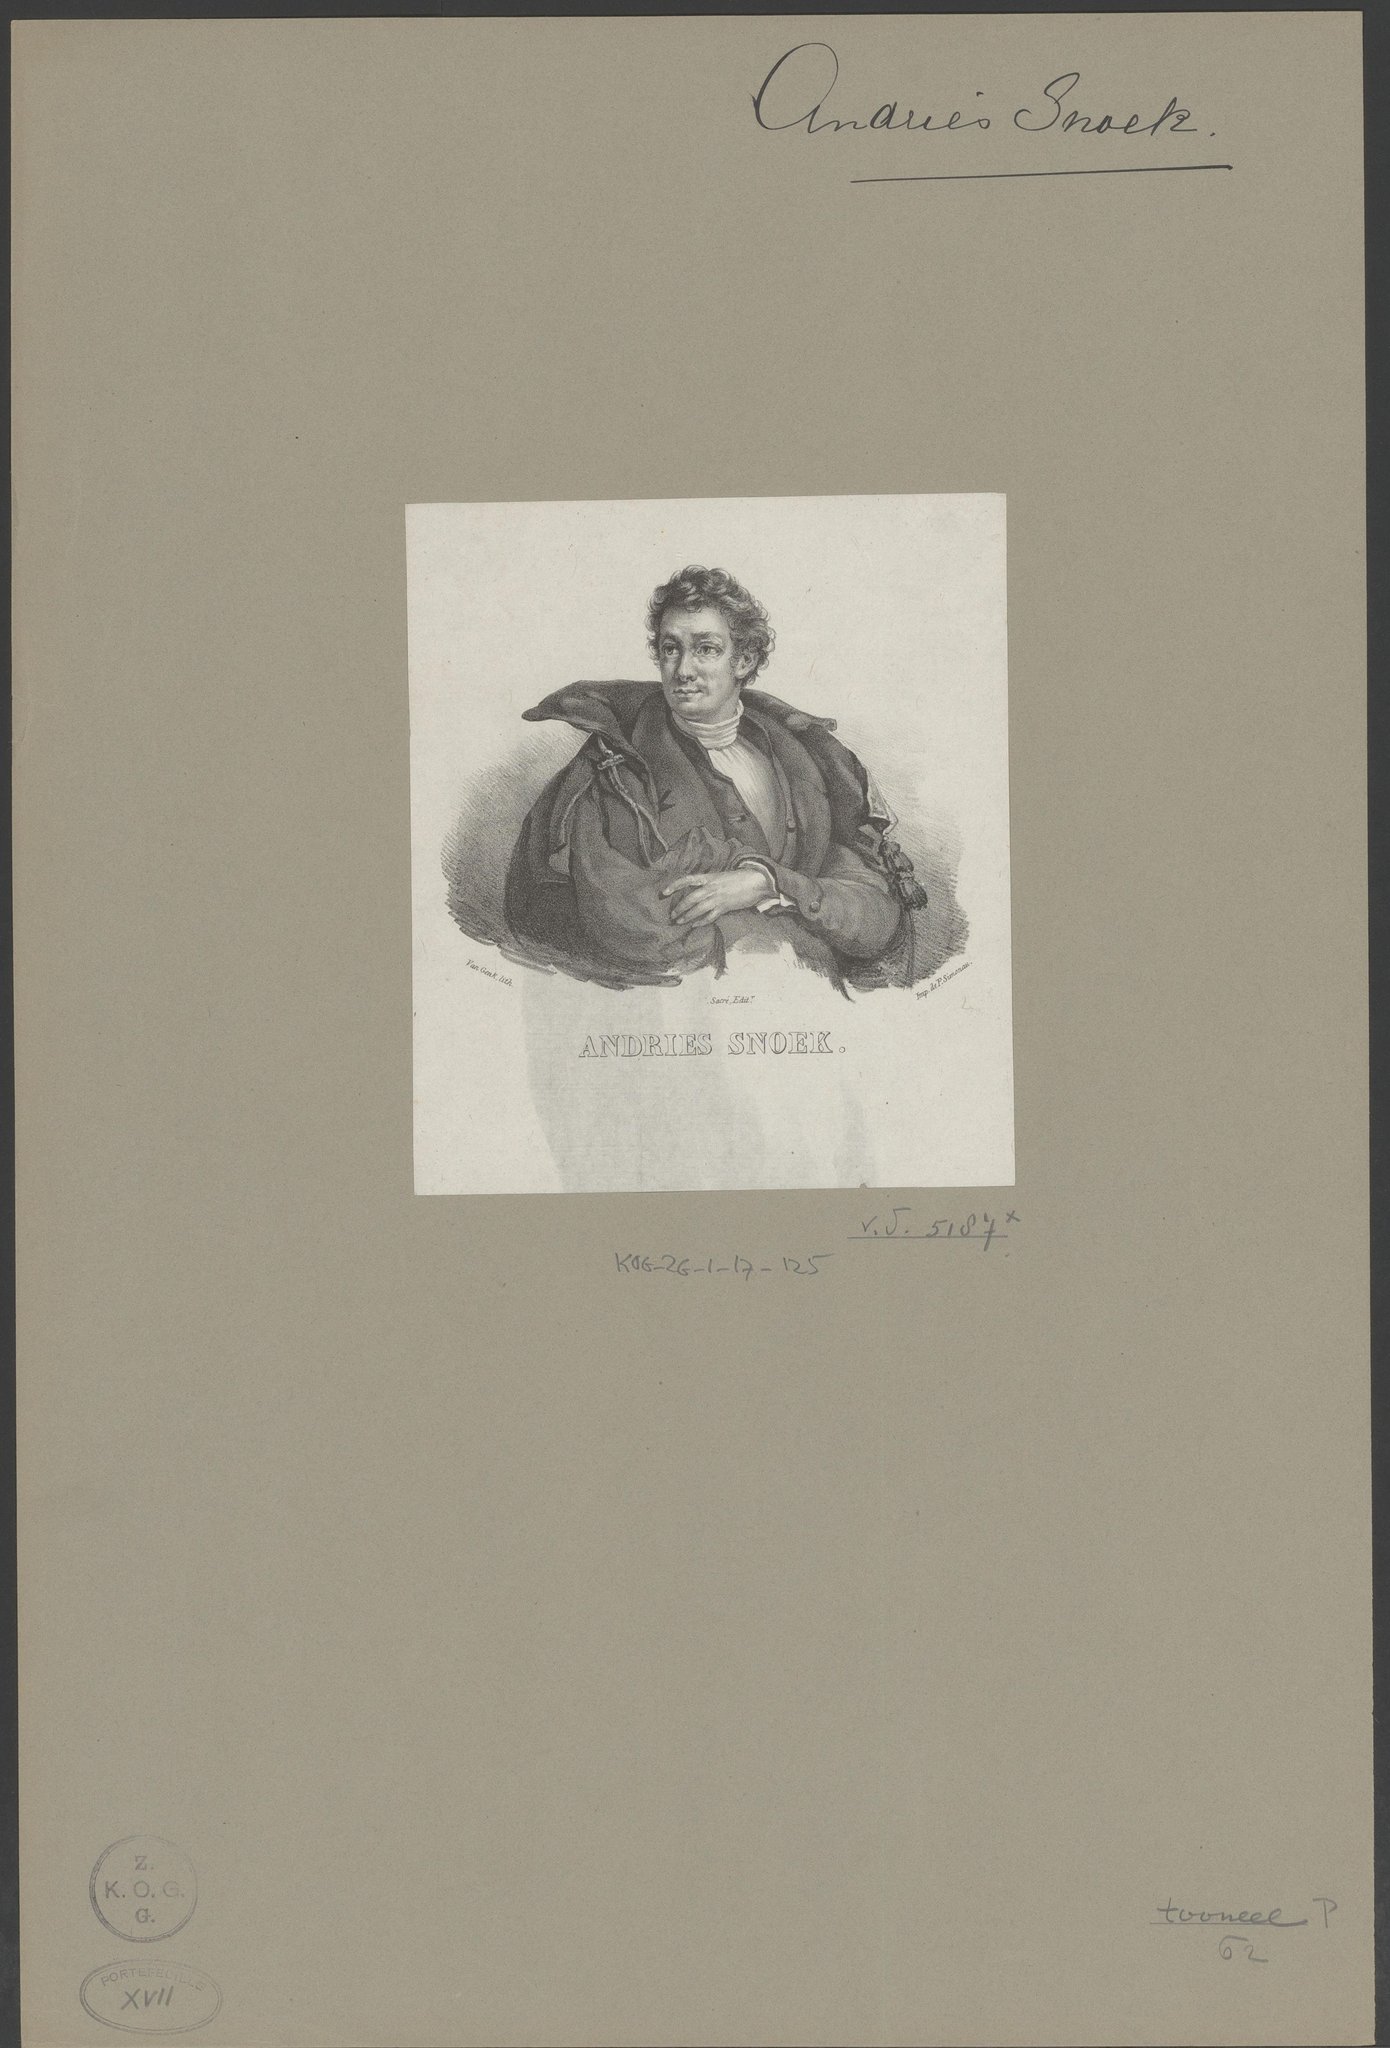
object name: print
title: Portret van Andreas Snoek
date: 1819-1828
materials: paper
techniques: lithograph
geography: brussels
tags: rotterdam, amsterdam, historical persons, portrait of actor, actress, actor (on the stage)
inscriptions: collector's mark: Lugt 1641, stamp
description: Onderwerpsrubrieken binnen de Atlas Zeden en Gewoonten: Tooneel, Portretten van toneelspelers.